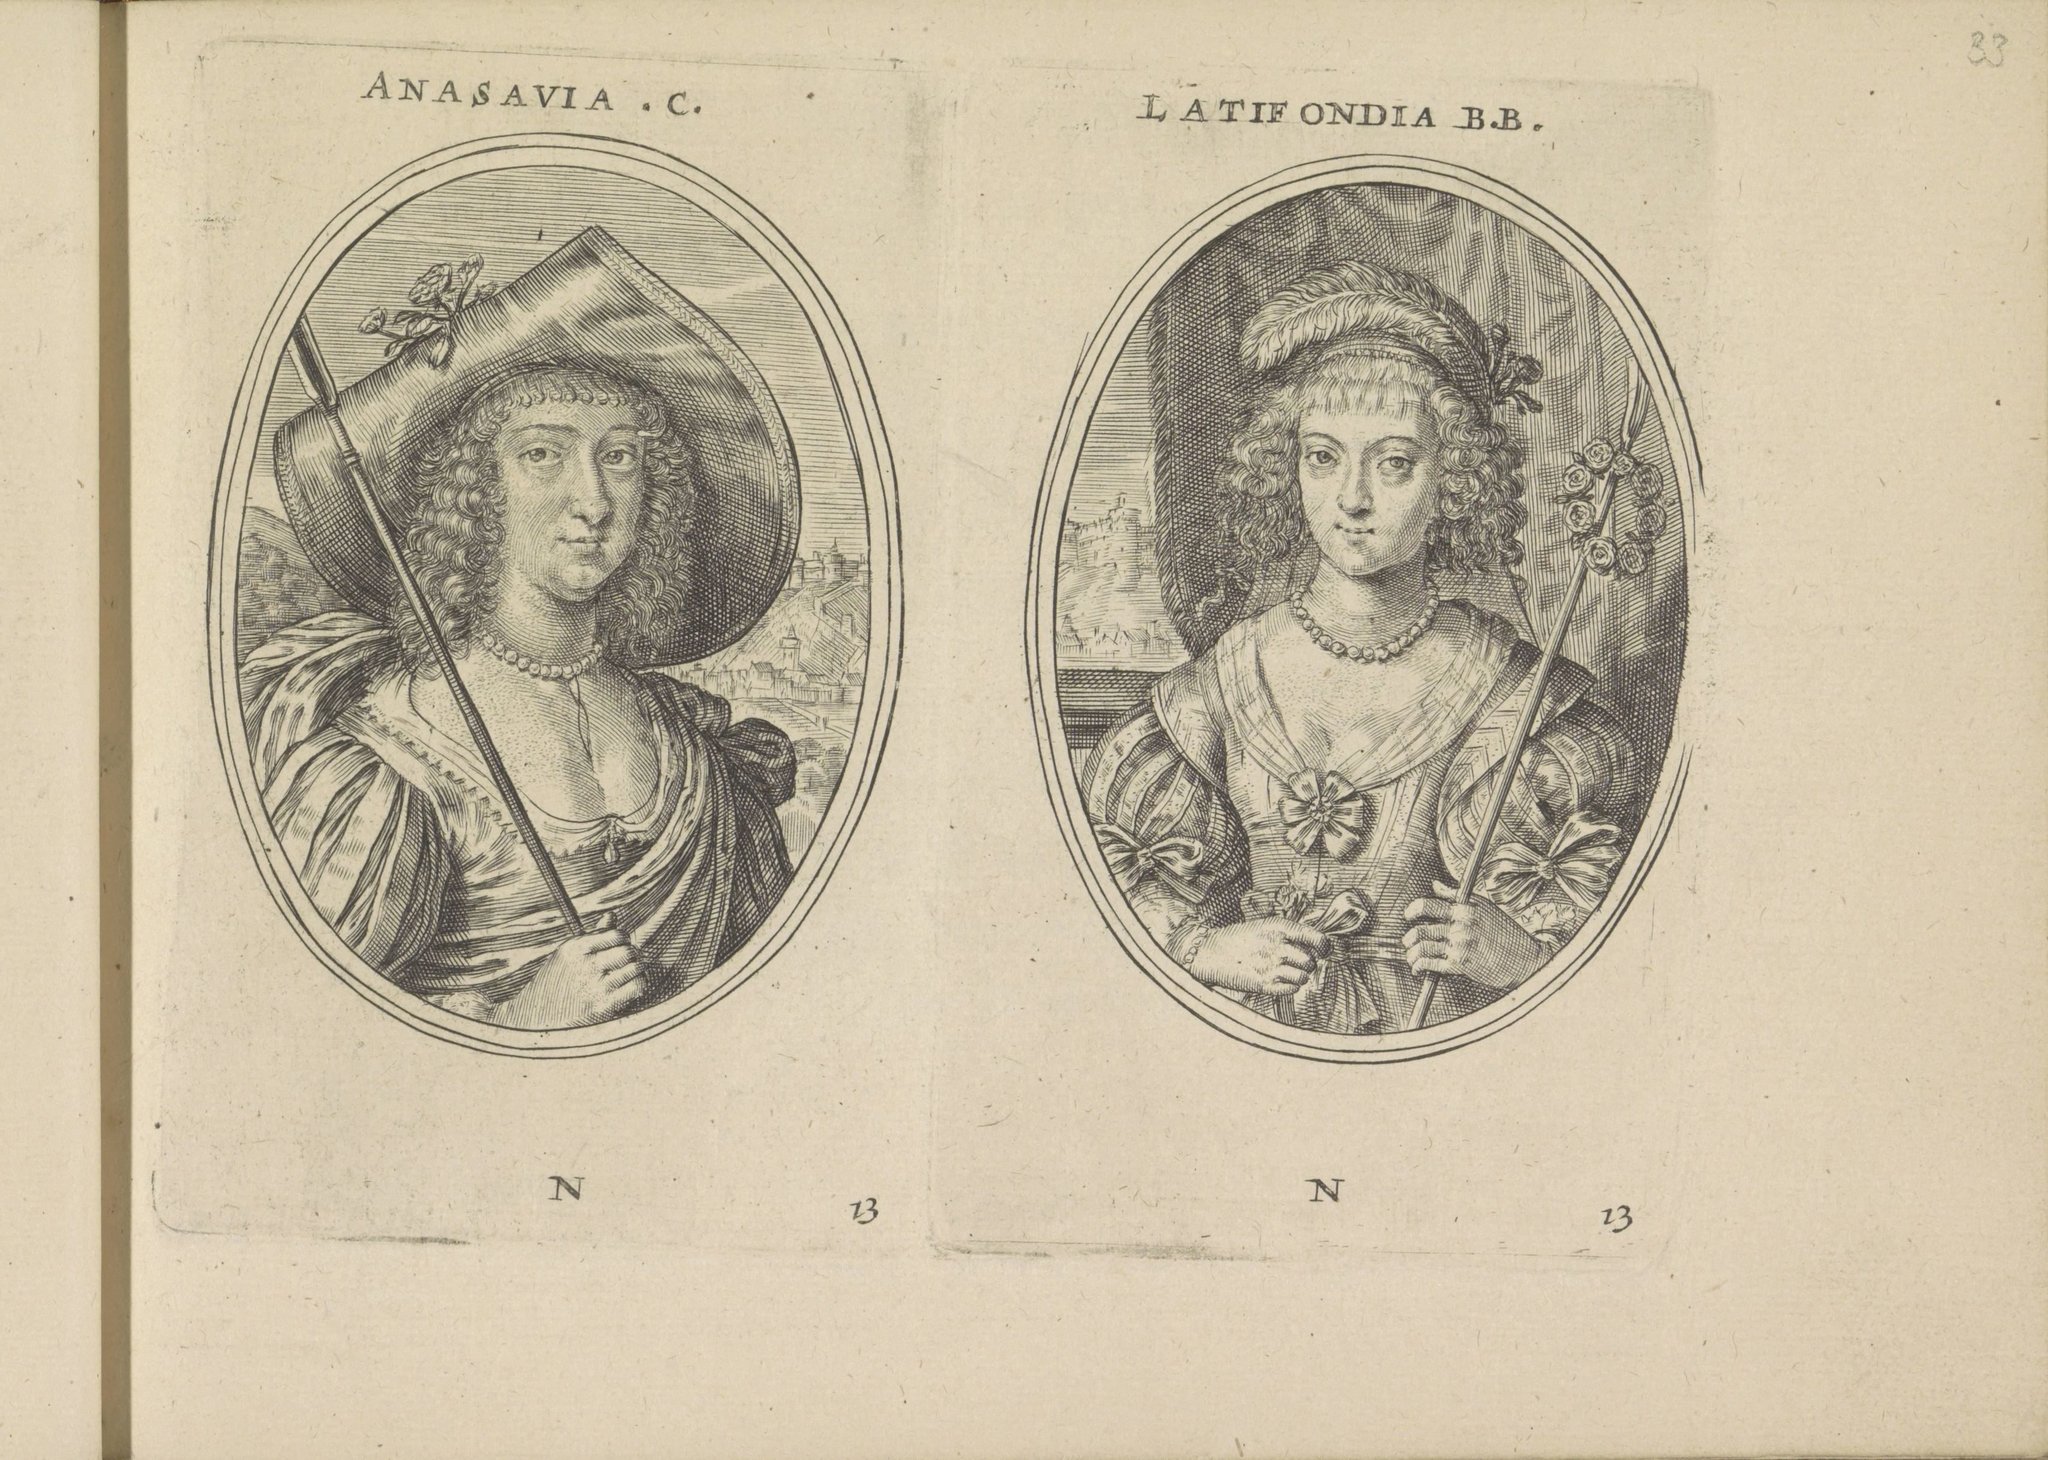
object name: print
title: Anasavia .C. / Latifondia B.B.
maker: crispijn van de passe (ii)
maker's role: draughtsman, print maker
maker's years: 1594-1670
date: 1640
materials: paper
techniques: engraving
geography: amsterdam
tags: female sex; woman, shepherd's crook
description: Twee voorstellingen op een albumblad. Links het portret van gravin Anna van Nassau-Siegen als Anasavia C. Rechts mogelijk de barones van Brederode als Latifondia B.B. De vrouwen hebben een herdersstaf in de hand. Op de achtergrond van beide voorstellingen enkele gebouwen. Beide onderaan genummerd: N en 13. Het blad maakt deel uit van een album.